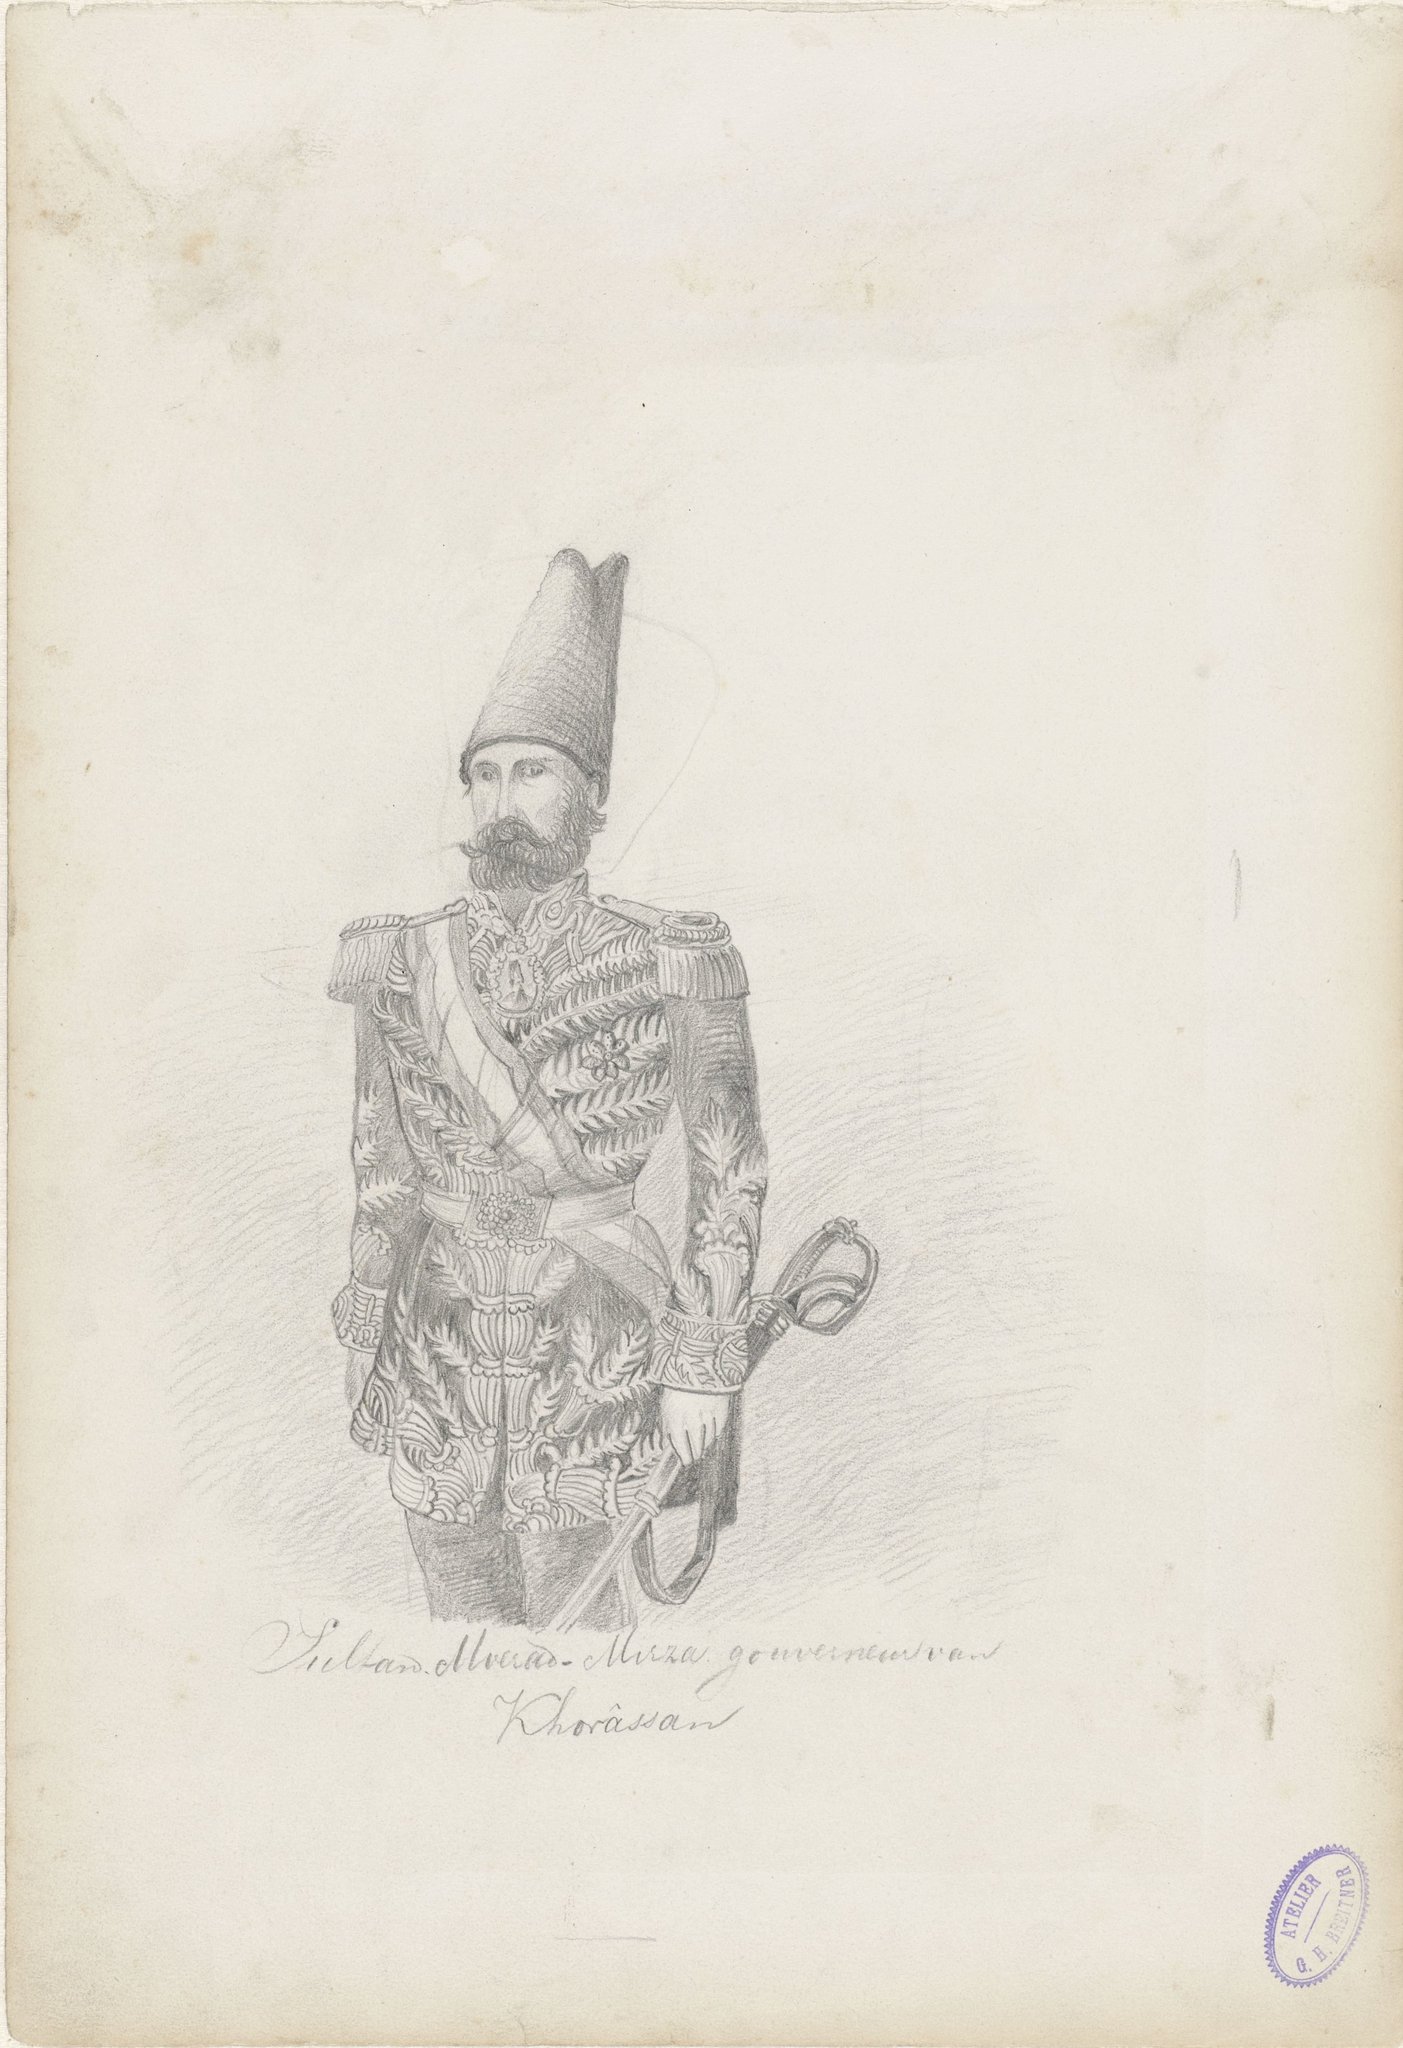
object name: drawing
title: Sultan Murad Mirze, gouverneur van Khorasan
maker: george hendrik breitner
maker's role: draughtsman, painter, print maker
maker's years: 1857-1923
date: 1867-1923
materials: paper, pencil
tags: historical persons